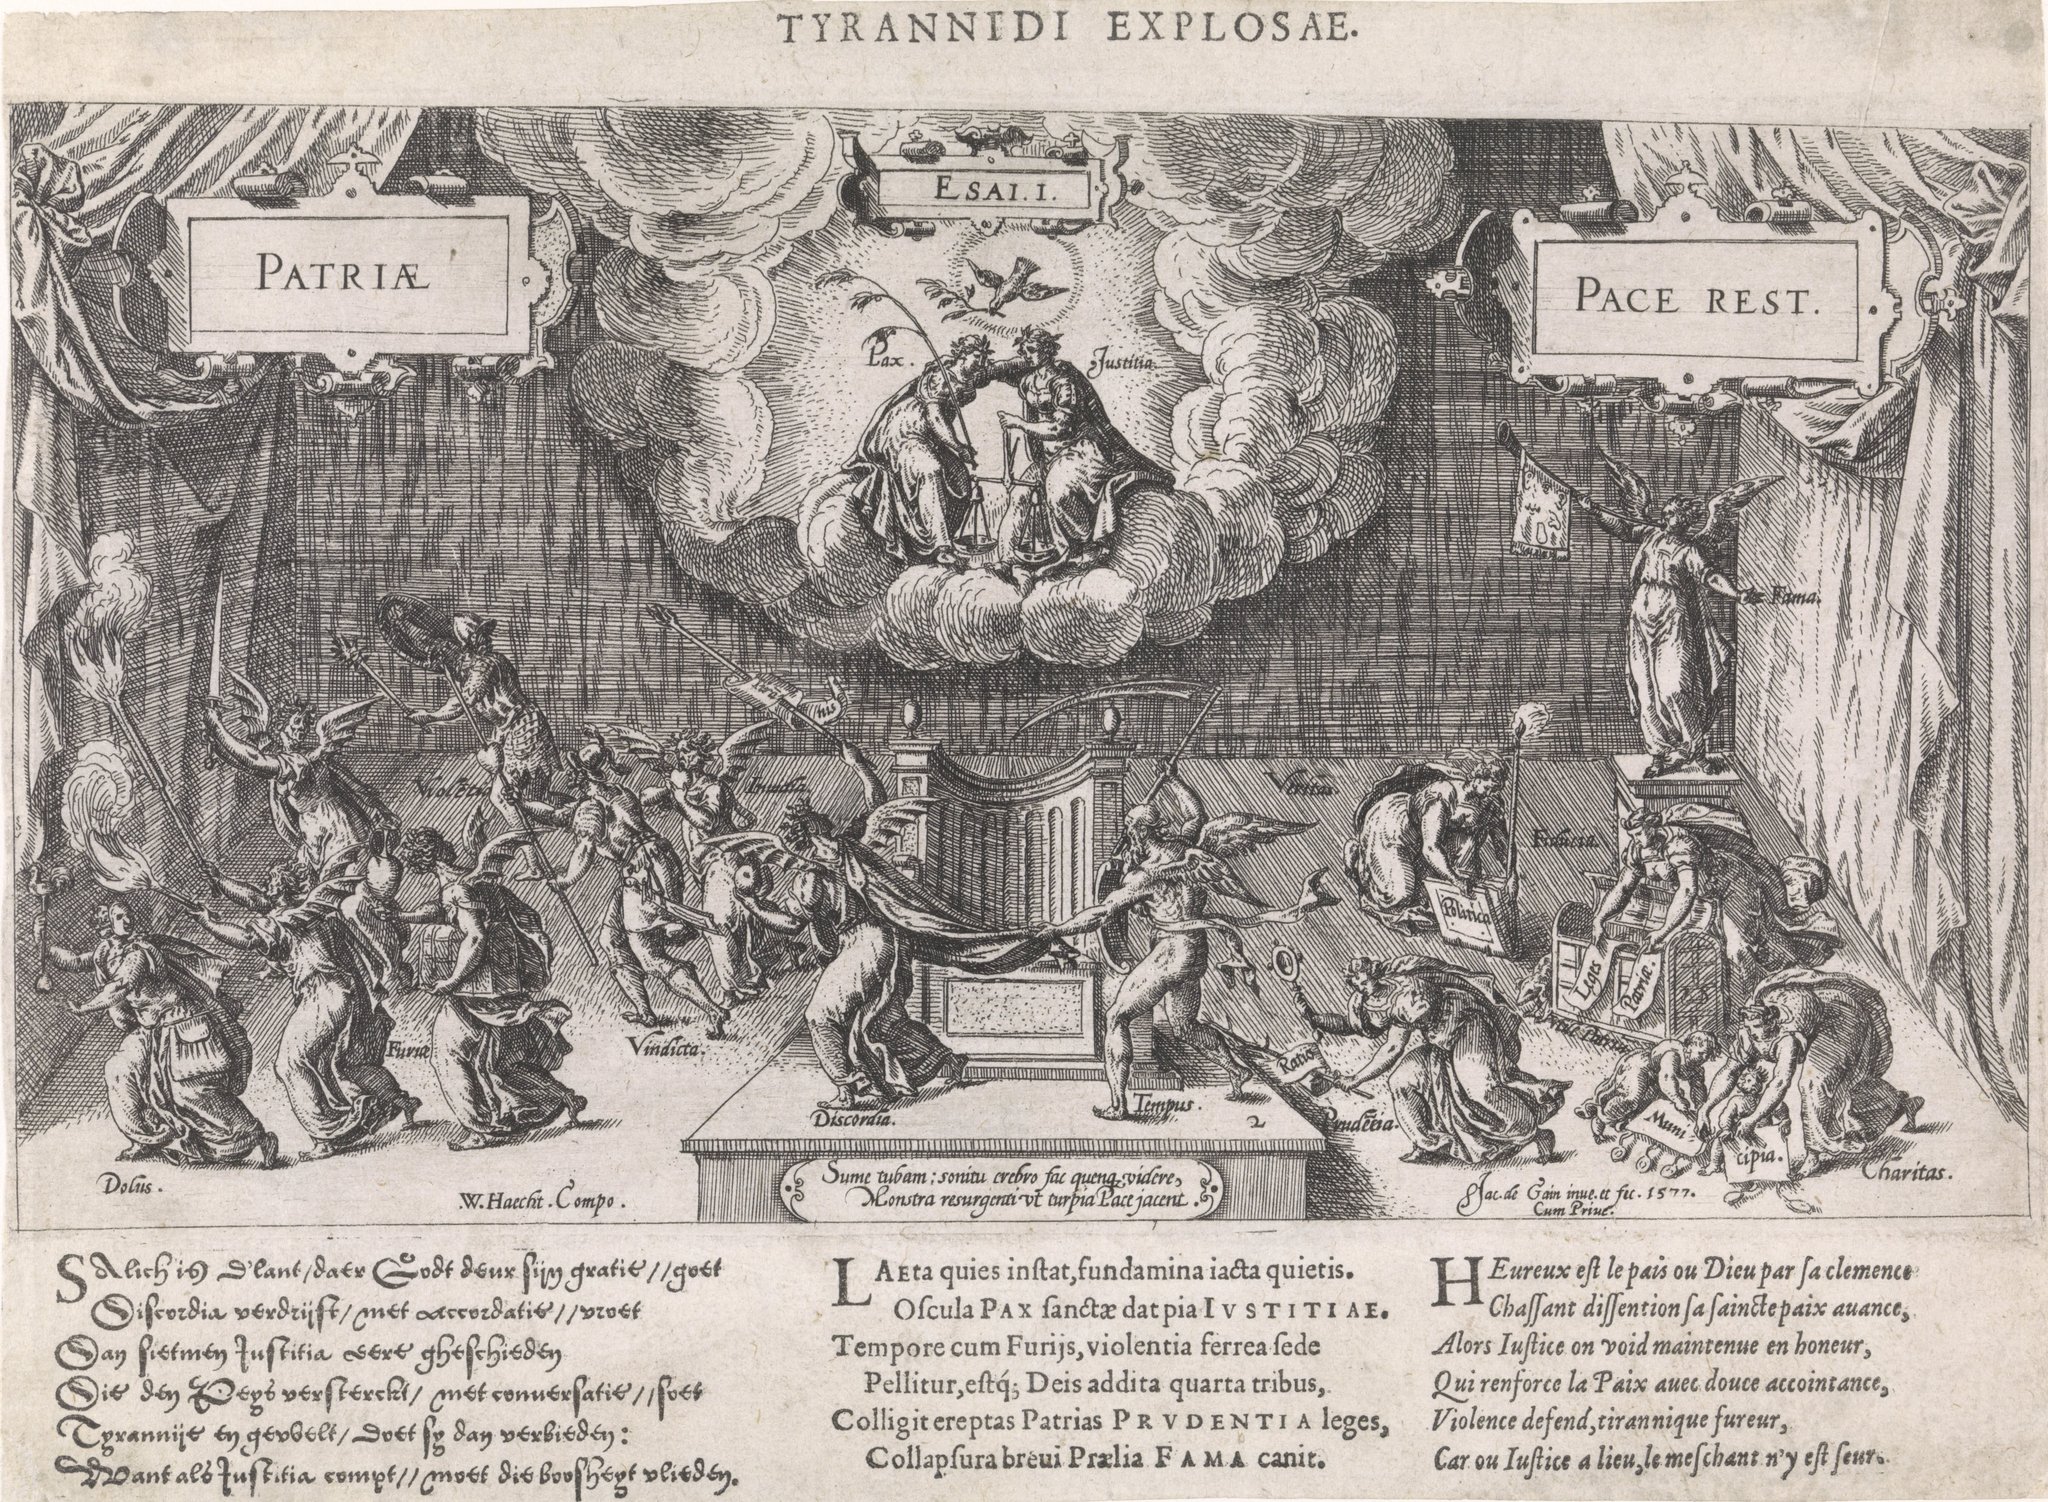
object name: propagandaprent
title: Tyrannidi Explosae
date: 1577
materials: paper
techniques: etching, letterpress printing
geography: antwerp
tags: don juan van oostenrijk, justice, 'justitia'; 'giustitia divina' (ripa) ~ one of the four cardinal virtues, symbols, allegories of peace, 'pax'; 'pace' (ripa), fame; 'fama', 'fama buona', 'fama chiara' (ripa), father time, man with wings and scythe, the arts of the stage: ballet, theatre, musical drama, motion picture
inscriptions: collector's mark: Lugt 2760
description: Toneel waarin de Tijd een einde maakt aan de heerschappij van Tweedracht, allegorisch verbeeld als een strijd tussen goed en kwaad. Links vluchten de personificaties van ondeugden van het toneel. In de wolken omhelzen de personificaties van Vrede (Pax) en Rechtvaardigheid (Justitia) elkaar, rechts blaast Faam op haar bazuin. In de voorstelling cartouches met opschriften in het Latijn. Onder de voorstelling gedrukt drie verzen van elk 6 regels in het Nederlands, Latijn en Frans.